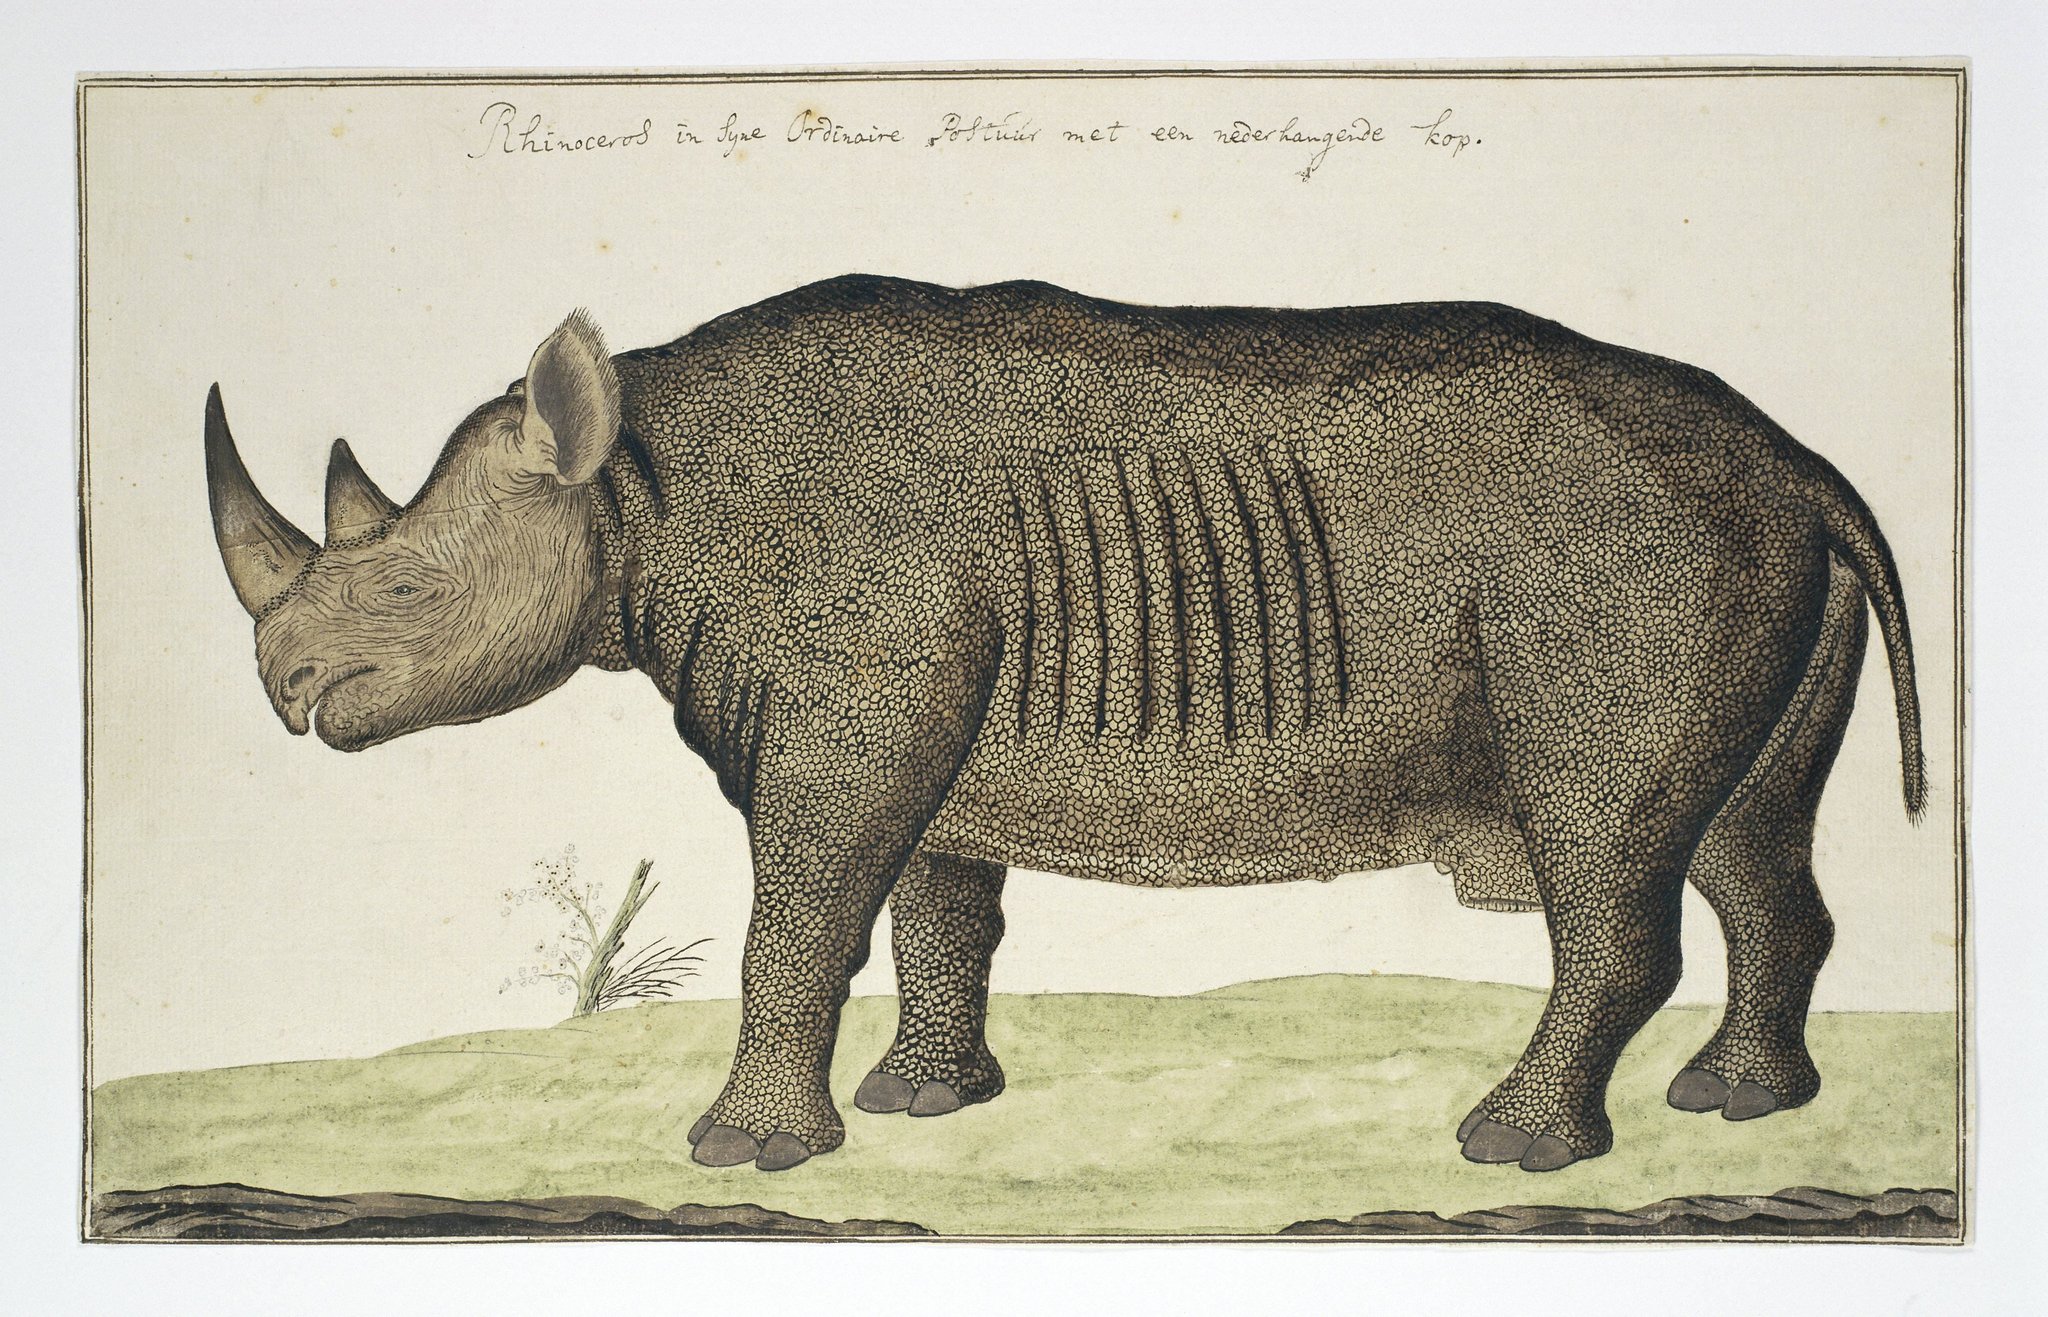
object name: drawing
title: Diceros bicornis (Black Rhinoceros)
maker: robert jacob gordon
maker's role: draughtsman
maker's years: 1743-1795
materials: chalk, ink, paper, pencil, watercolor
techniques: brush, pen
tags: hoofed animals: rhinoceros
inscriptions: annotation: ‘Rhinoceros in Syne ordinaire Postuur met een nederhangende kop.’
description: Alle neushoorntekeningen zijn gebaseerd op het eerste exemplaar, G. 205.